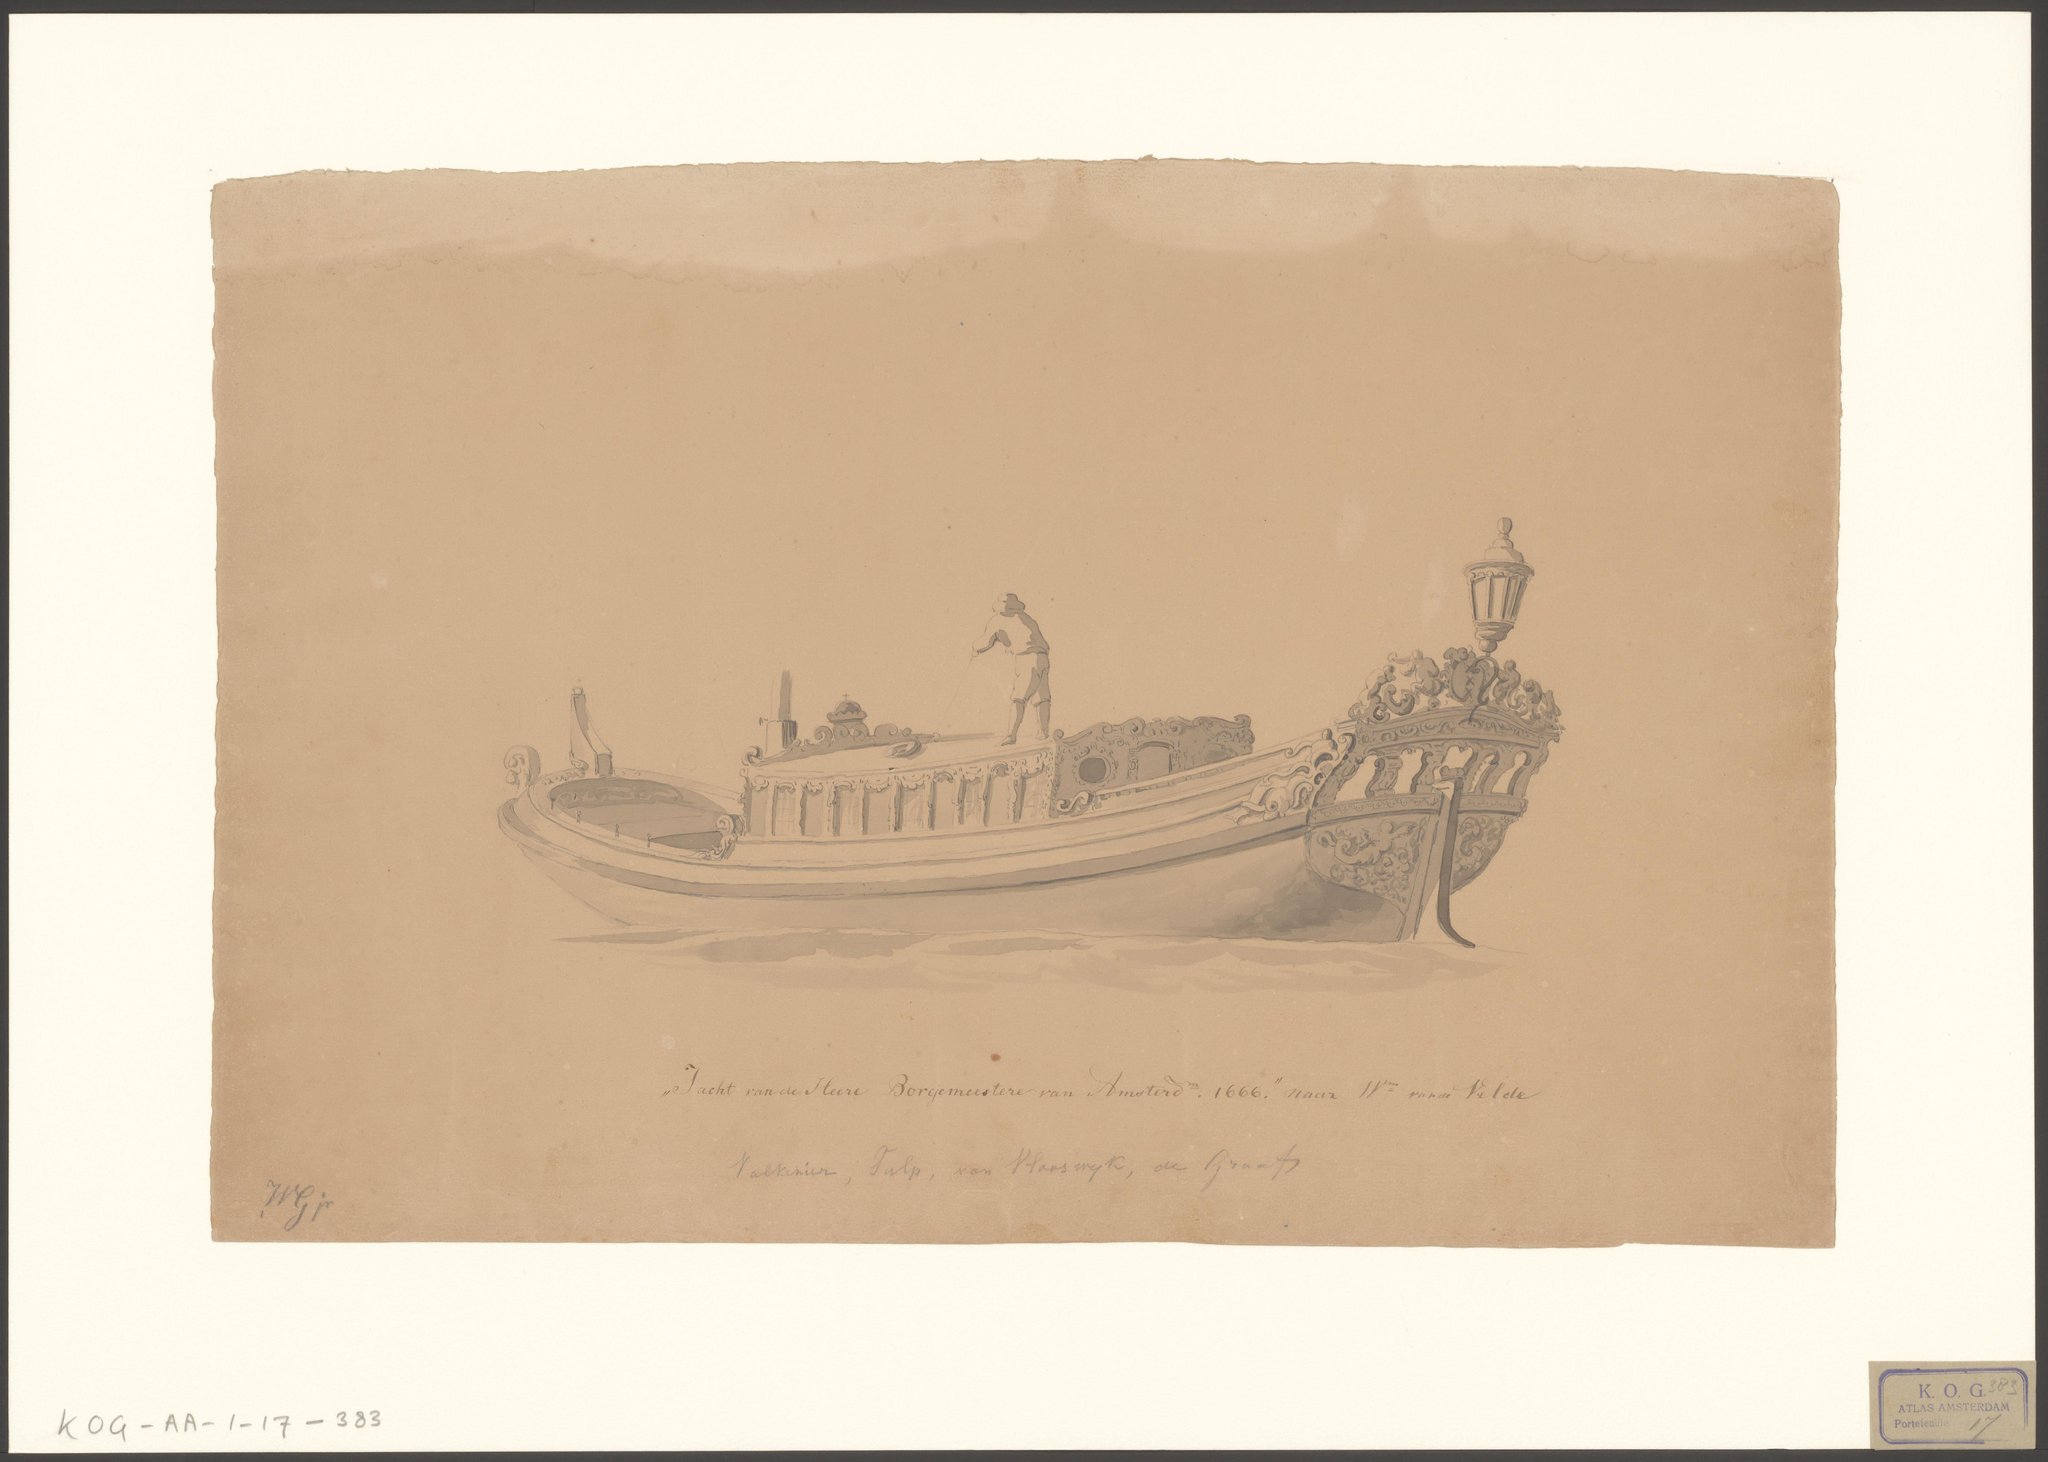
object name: drawing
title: Gezicht op de jacht van de burgemeester van Amsterdam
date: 1800-1899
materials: ink, paper, pencil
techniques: brush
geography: amsterdam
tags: boat propelled by man or animal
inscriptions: inscription: ‘Port. 17 - 383’, collector's mark: ‘17’ Lugt 1641b, inscription: ‘"Jacht van de (...) Vlaaswijk, de Graaf’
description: Onderwerpsrubriek binnen de Atlas Amsterdam: Vaartuigen en Gebouwen ten dienste der Stedelijke Regeering en Administratie; Stadhuis (Prinsenhof).